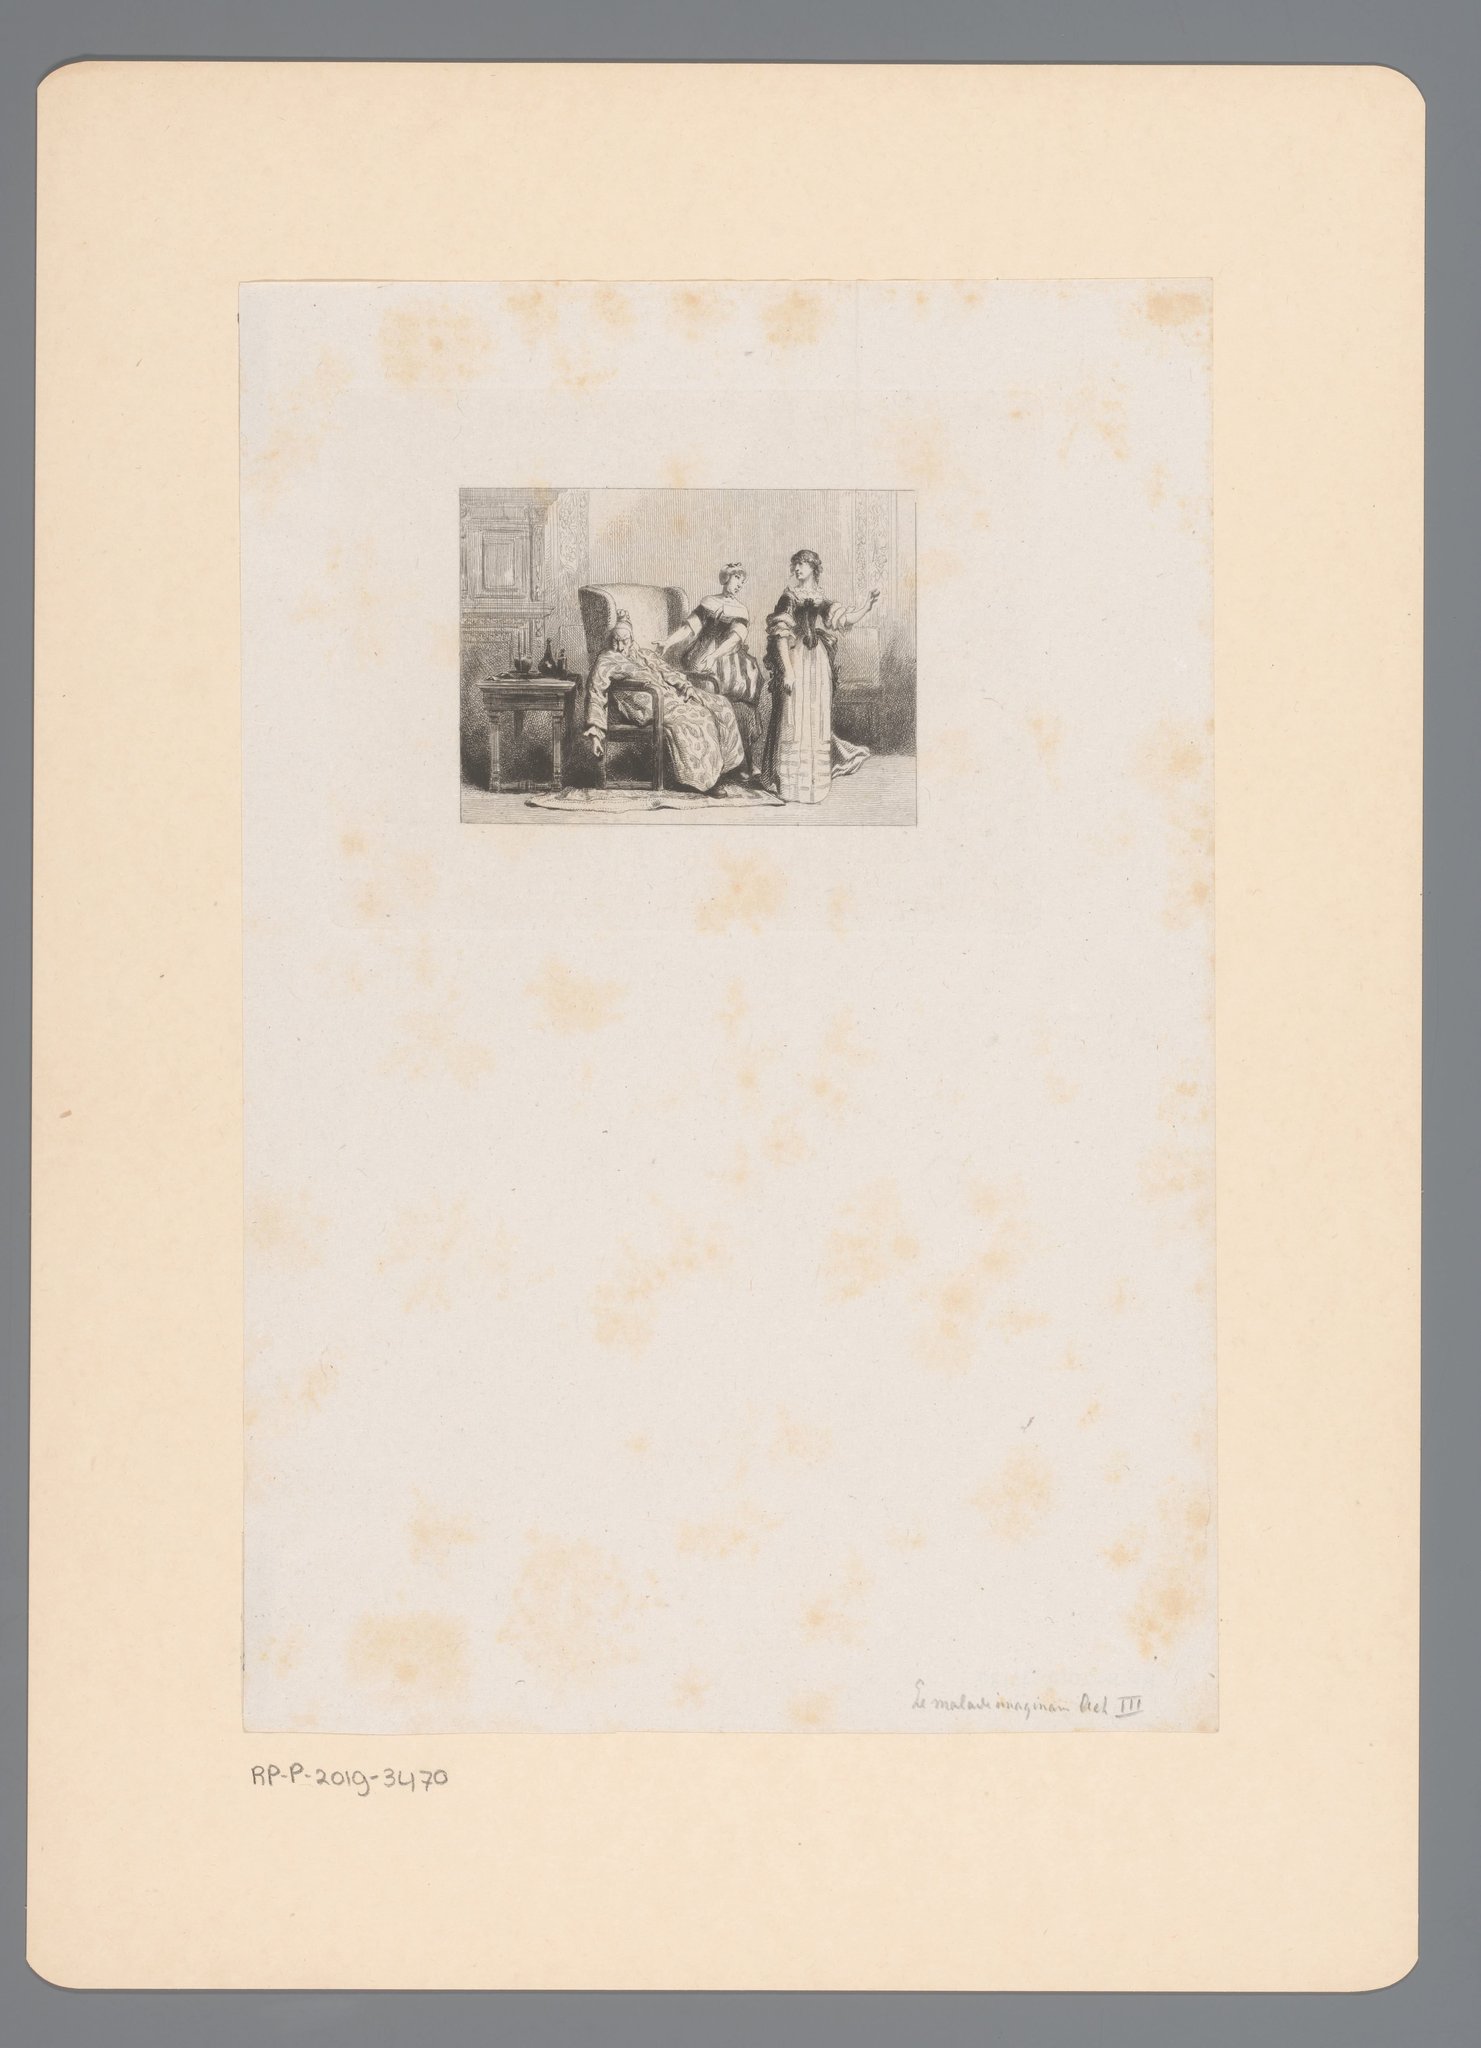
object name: print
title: Toneelstukken van Molière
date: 1878-1879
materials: paper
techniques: drypoint, etching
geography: tours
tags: hypochondriac, apparent death, theatre, theatrical performance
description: Akte III, scène XIII uit "Le Malade Imaginaire" van Molière. De hypochonder Argan ligt in een stoel en zijn dochters Toinette en Angélique staan erbij. Waarschijnlijk doet hij hier alsof hij dood is.